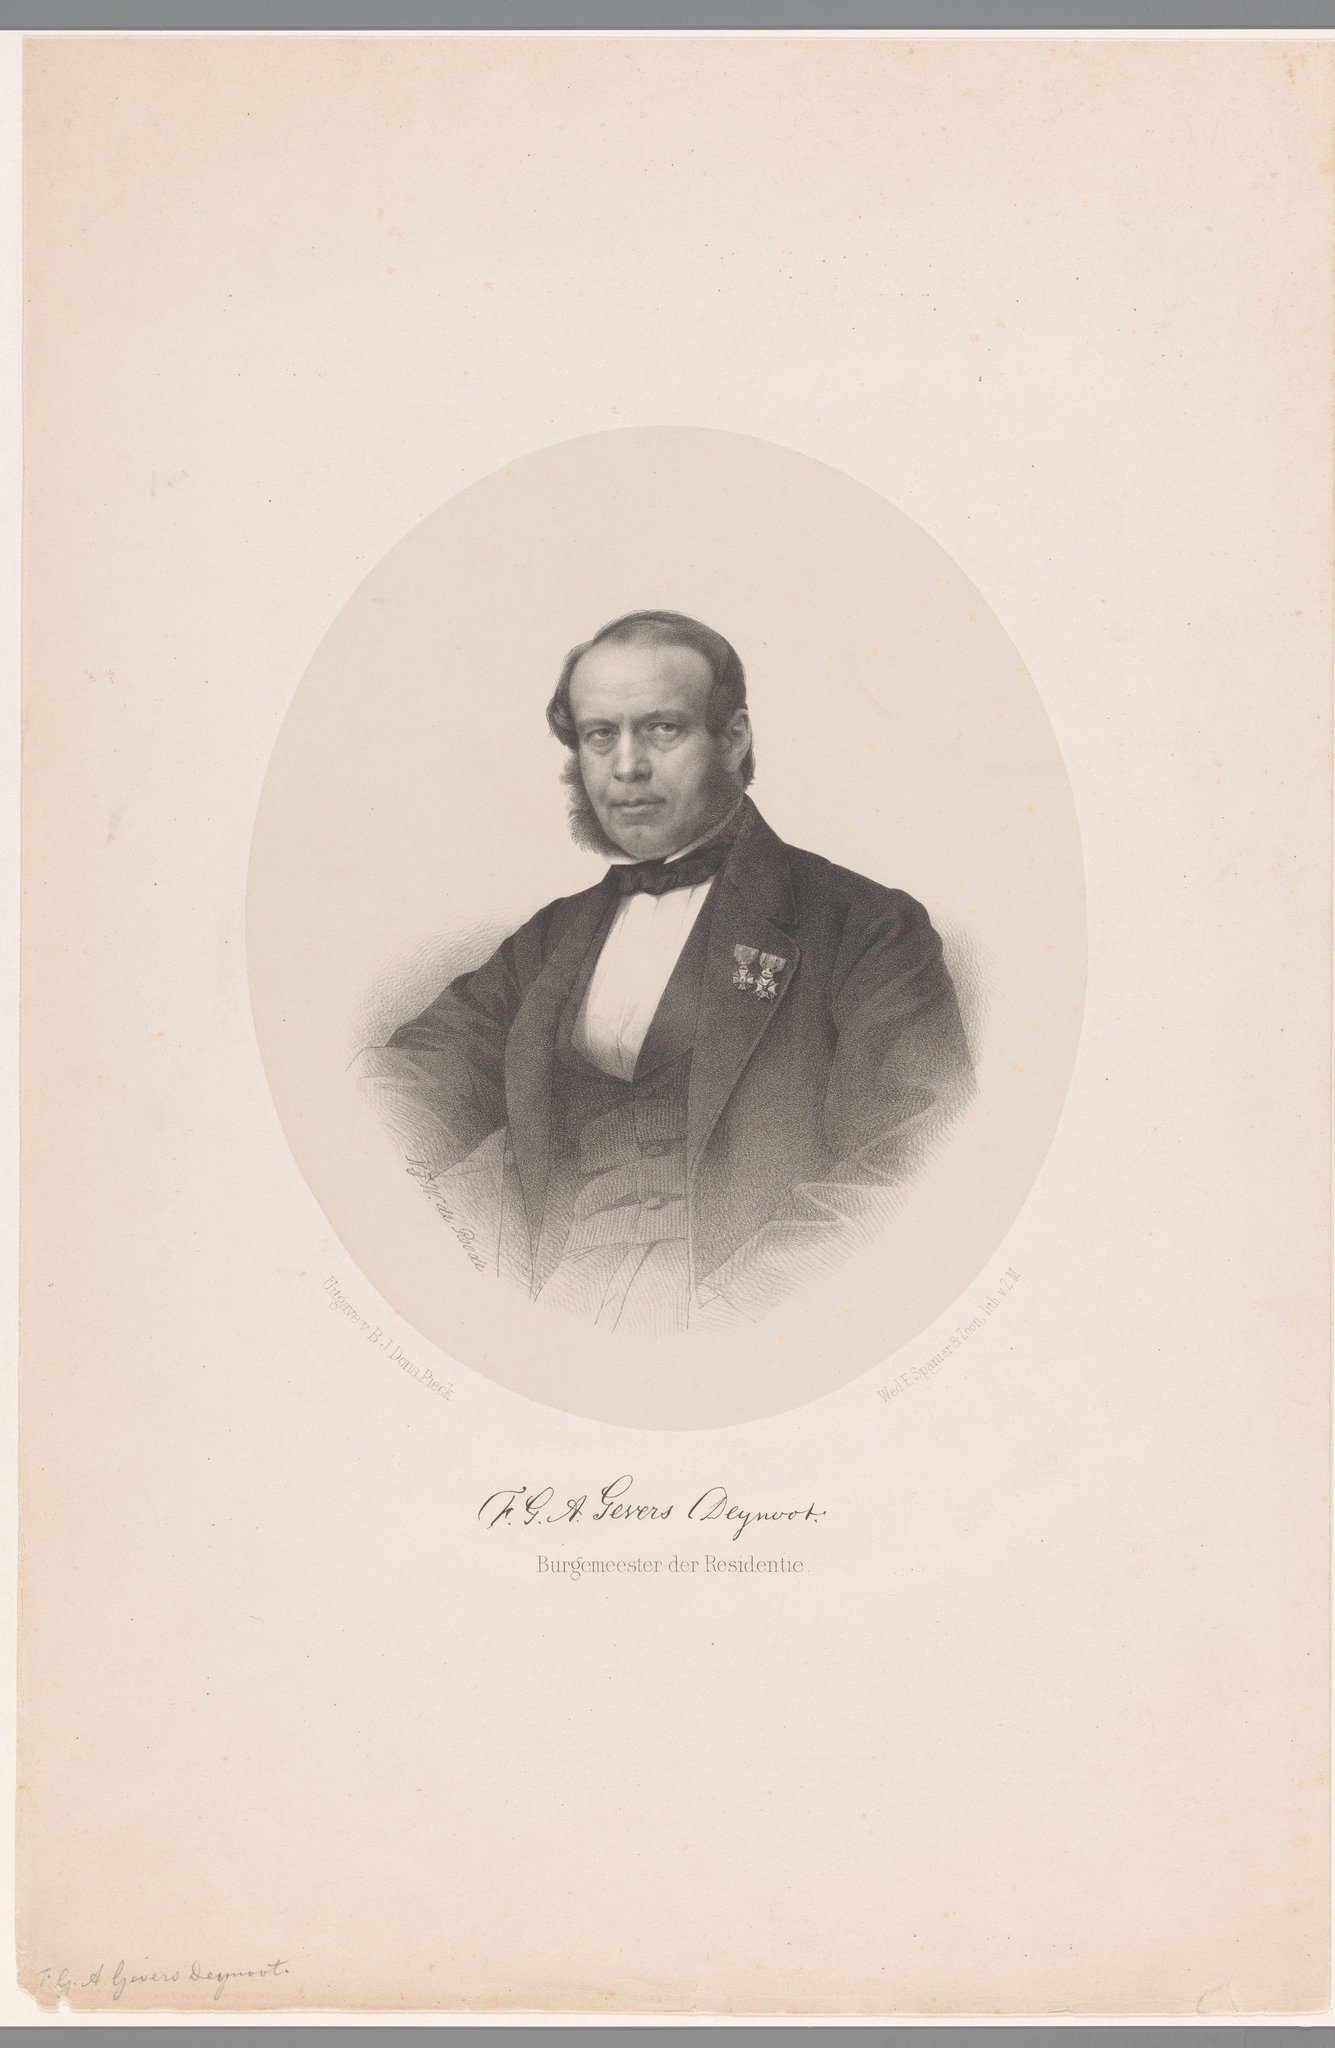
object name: print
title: Burgemeester der Residentie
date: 1863-1875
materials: paper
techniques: lithograph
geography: the hague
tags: rotterdam, mayor, françois gerard abraham gevers deynoot, historical persons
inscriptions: collector's mark: Lugt 2228